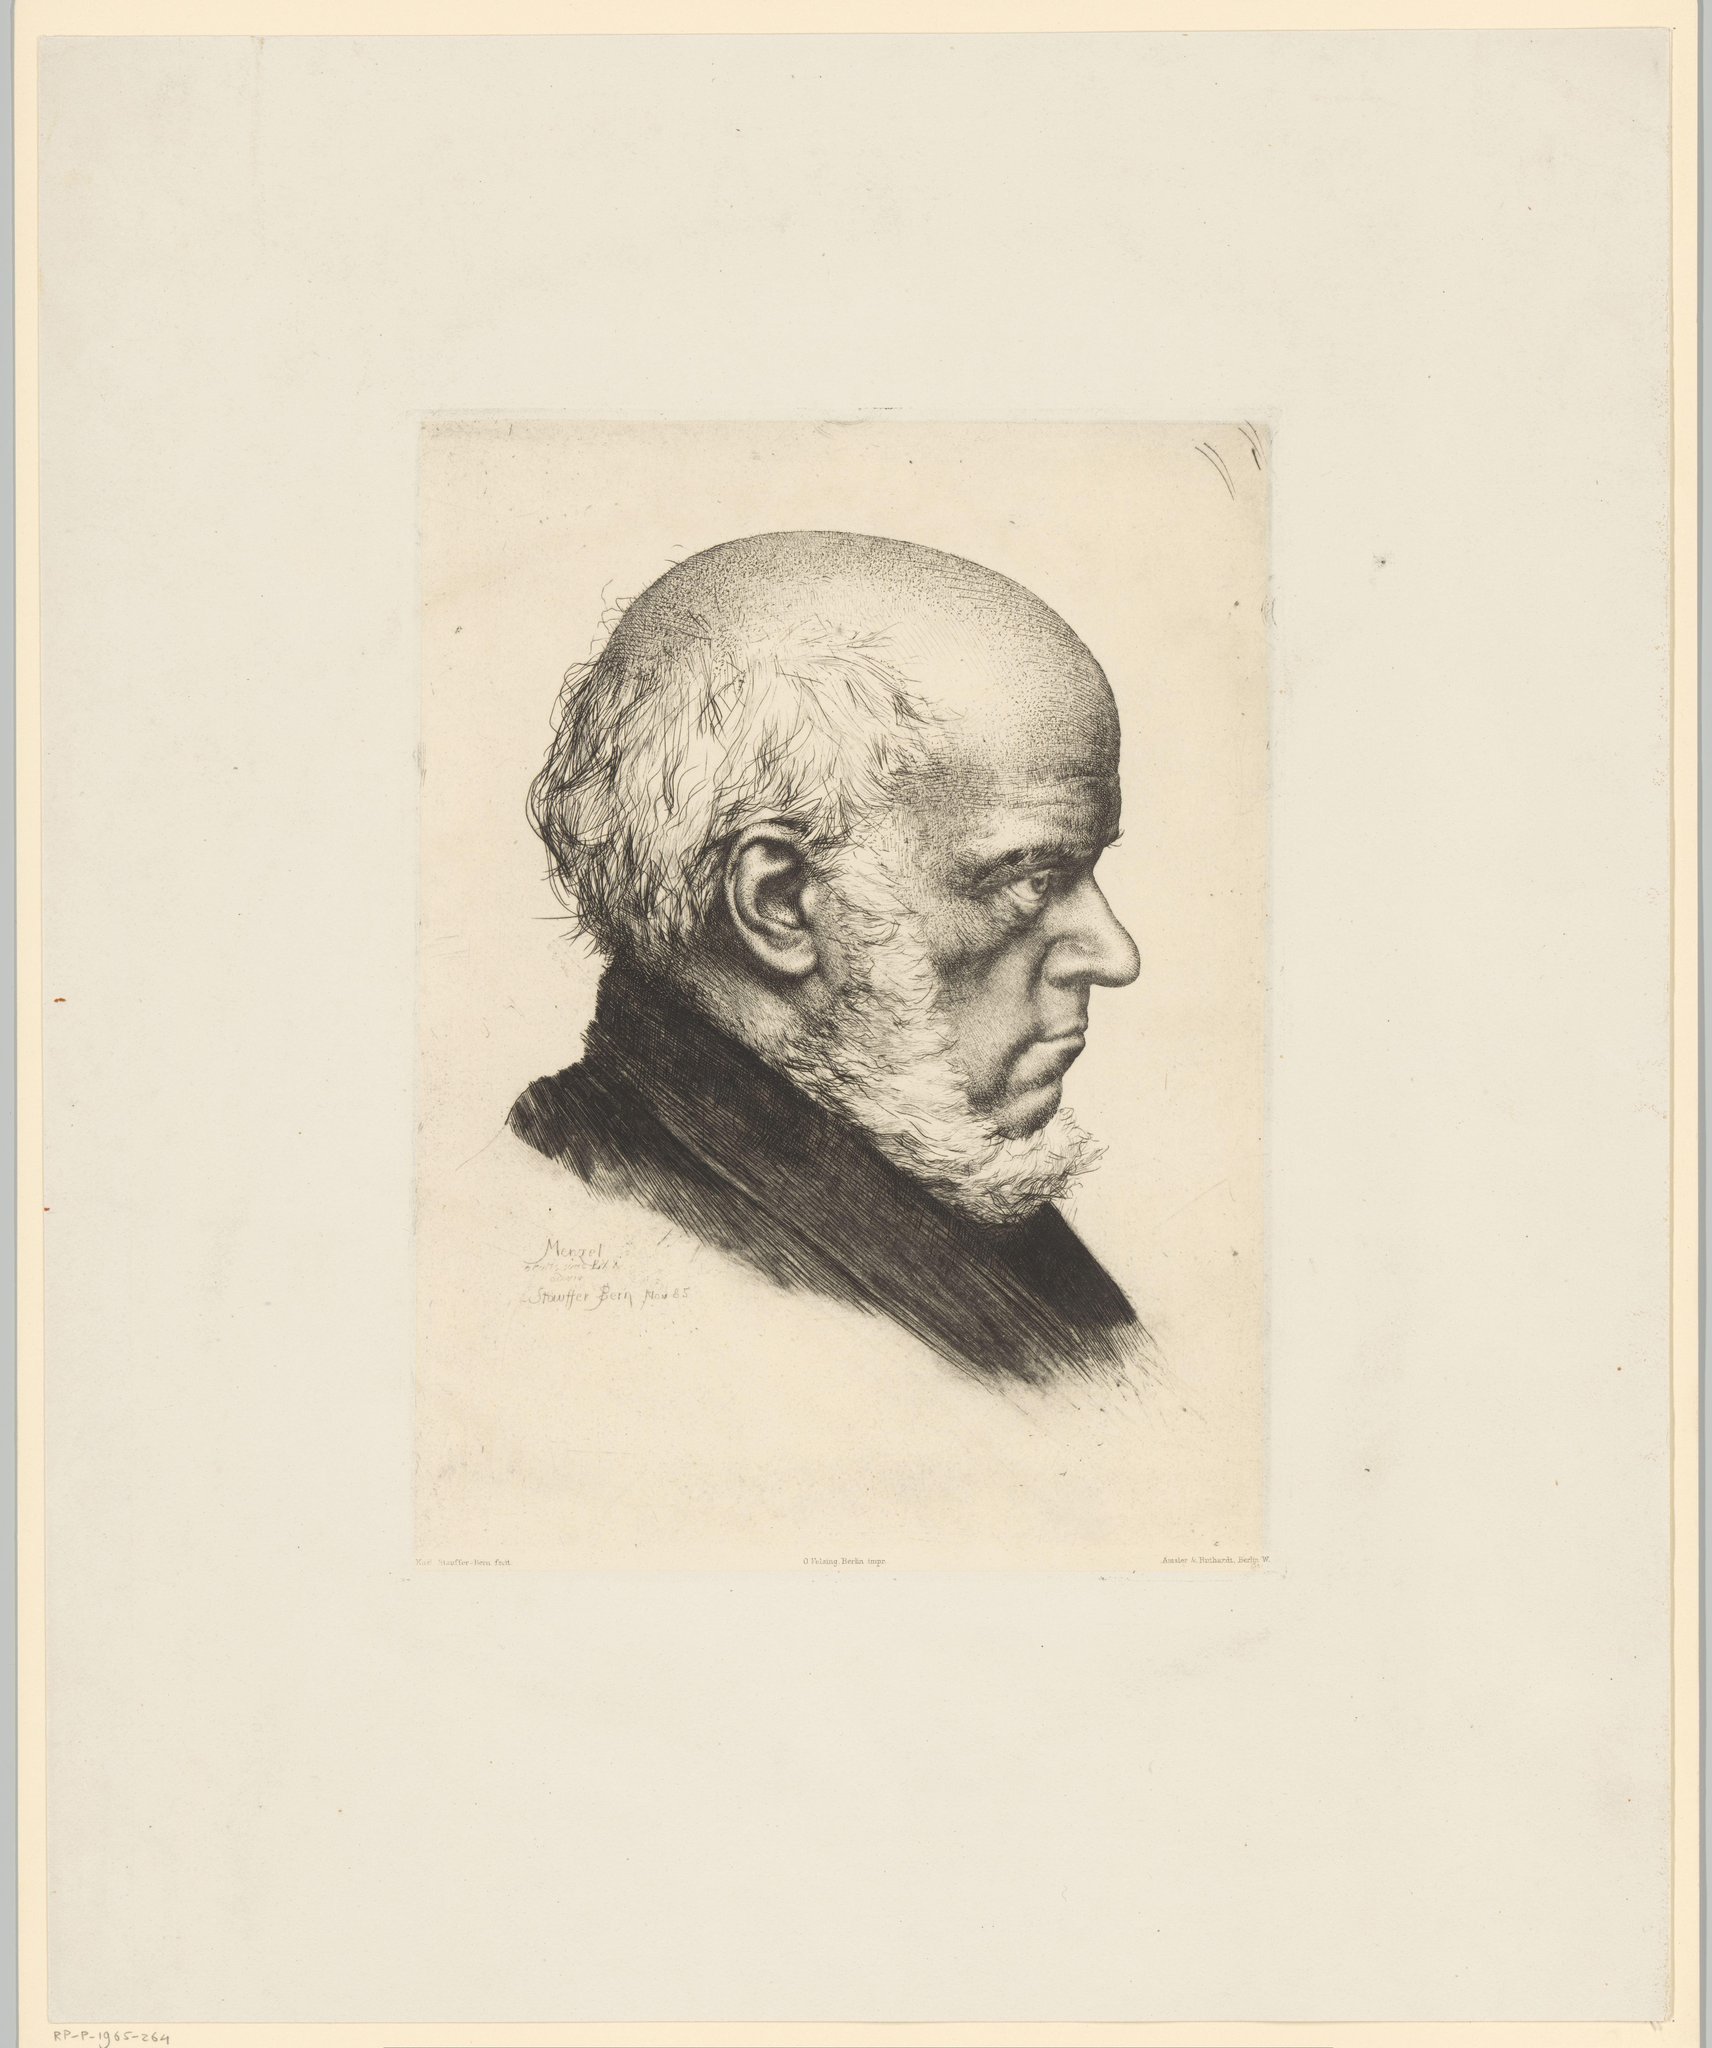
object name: print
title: Portret van Adolf Menzel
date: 1885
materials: paper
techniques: etching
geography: berlin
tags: berlin, print maker, draughtsman, adolph menzel, historical persons, portrait, self-portrait of artist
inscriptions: collector's mark: Lugt 2228